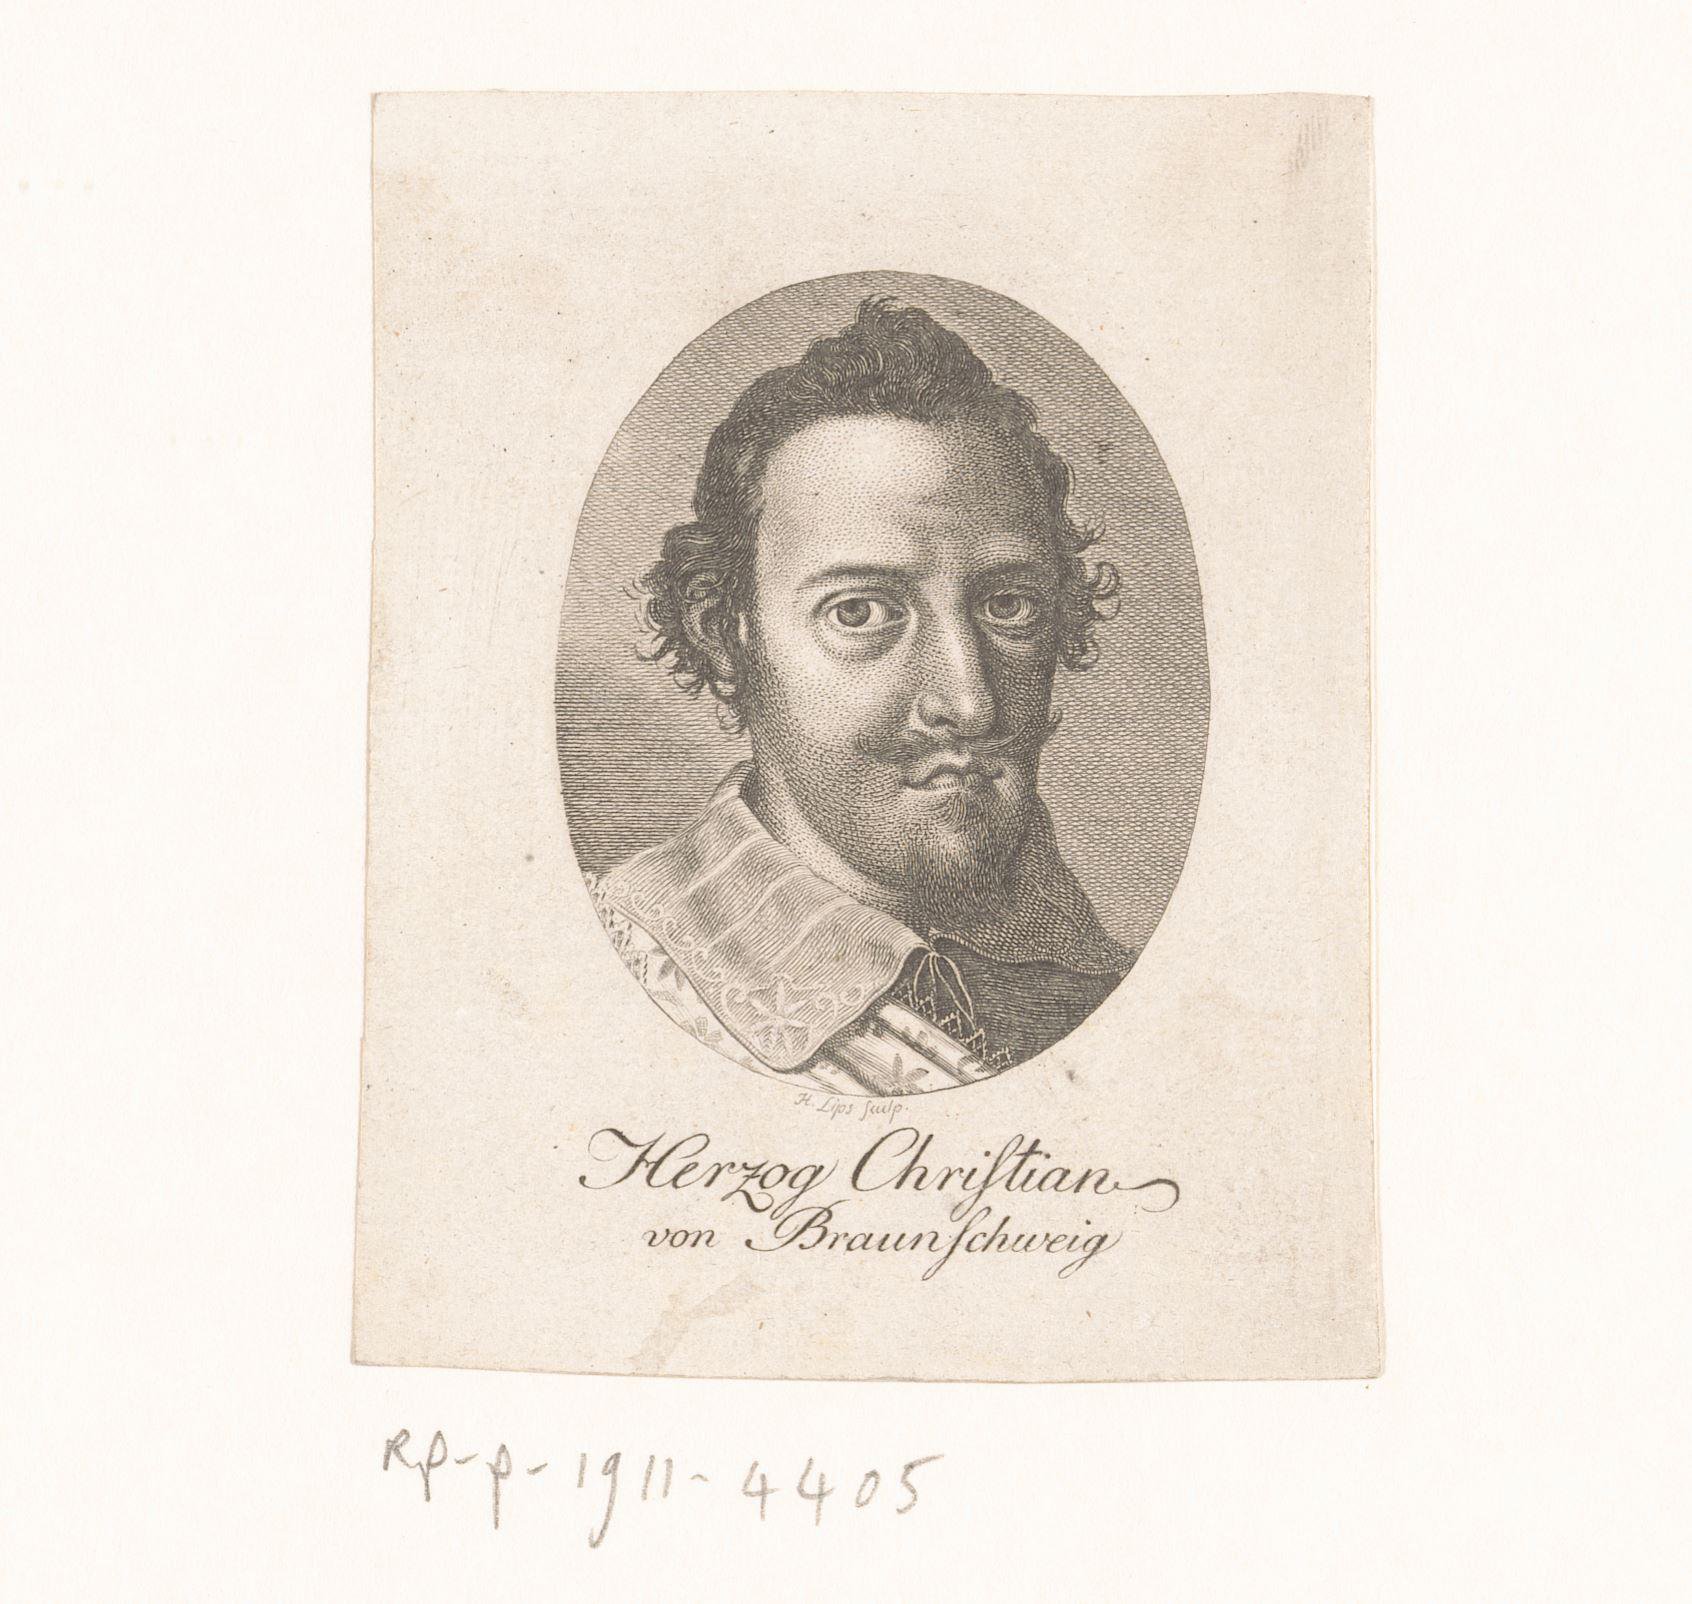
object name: print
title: Portret van Christiaan, hertog van Brunswijk-Lüneburg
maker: johann heinrich lips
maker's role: draughtsman, painter, print maker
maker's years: 1758-1817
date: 1793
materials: paper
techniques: engraving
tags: historical persons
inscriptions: collector's mark: Lugt 2228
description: Prent ook gebruikt in: Schiller, Friedrich von. Historischer Calender für Damen für das Jahr 1793. Leipzig: G.J. Göschen, 1793.